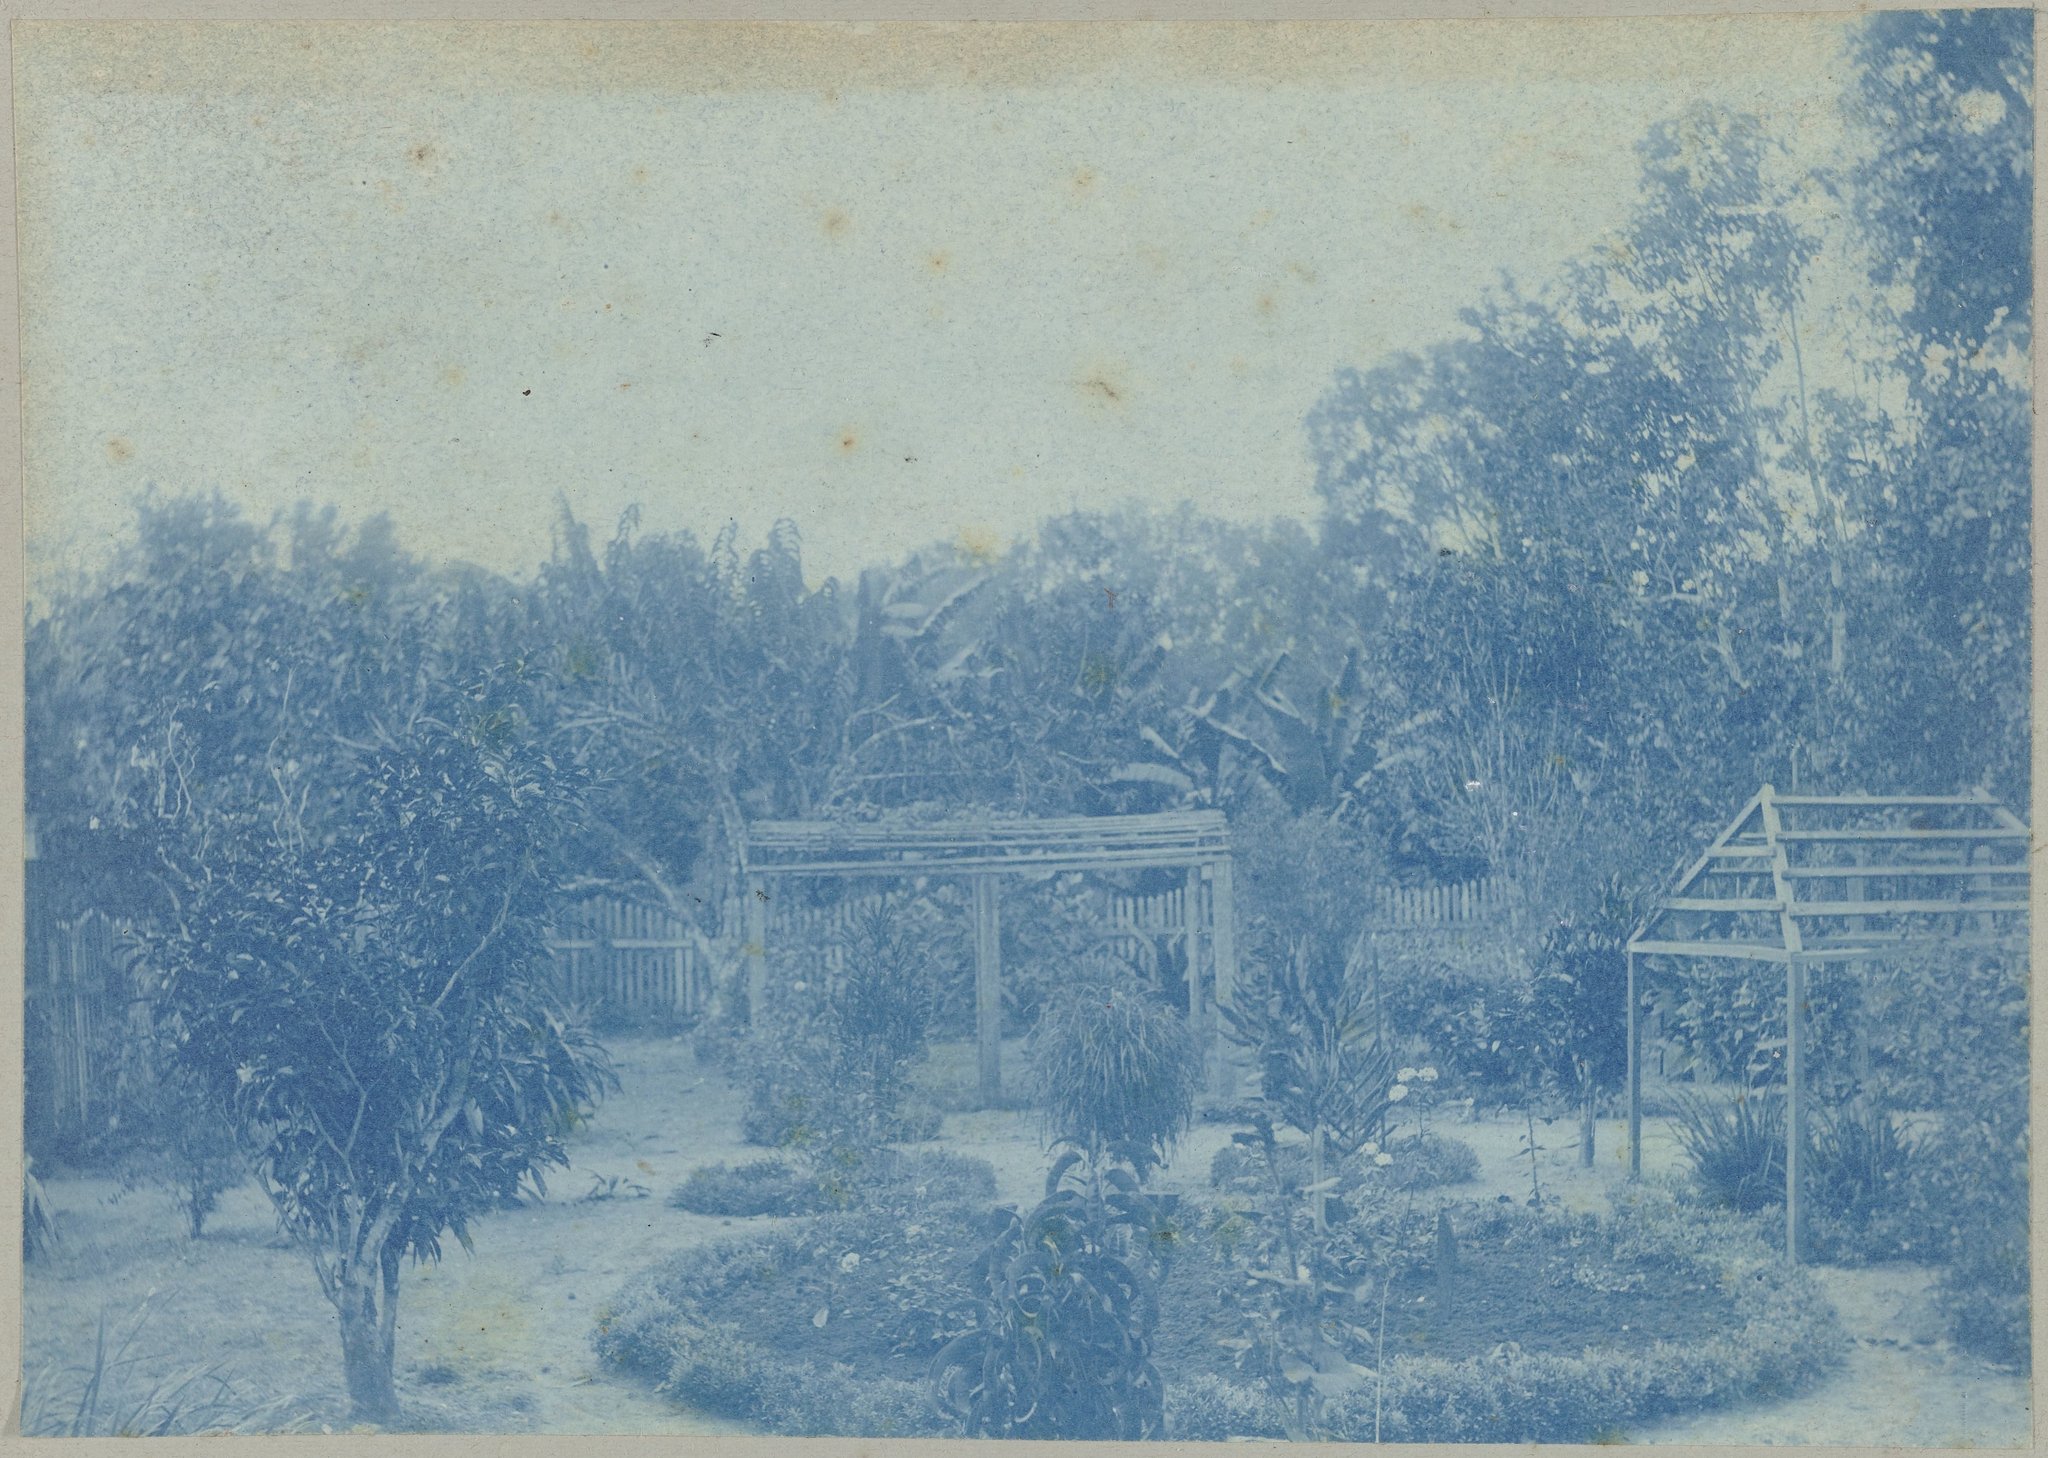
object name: photograph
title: Tuin op Ma retraite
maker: hendrik doijer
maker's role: engineer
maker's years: 1863-1925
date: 1903-1910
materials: photographic support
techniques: cyanotype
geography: suriname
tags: suriname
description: Gezicht in de tuin met aangeplante bomen en struiken op de plantage Ma retraite. Onderdeel van het fotoalbum Souvenir de Voyage (deel 2), over het leven van de familie Doijer in en rond de plantage Ma Retraite in Suriname in de jaren 1903-1910.